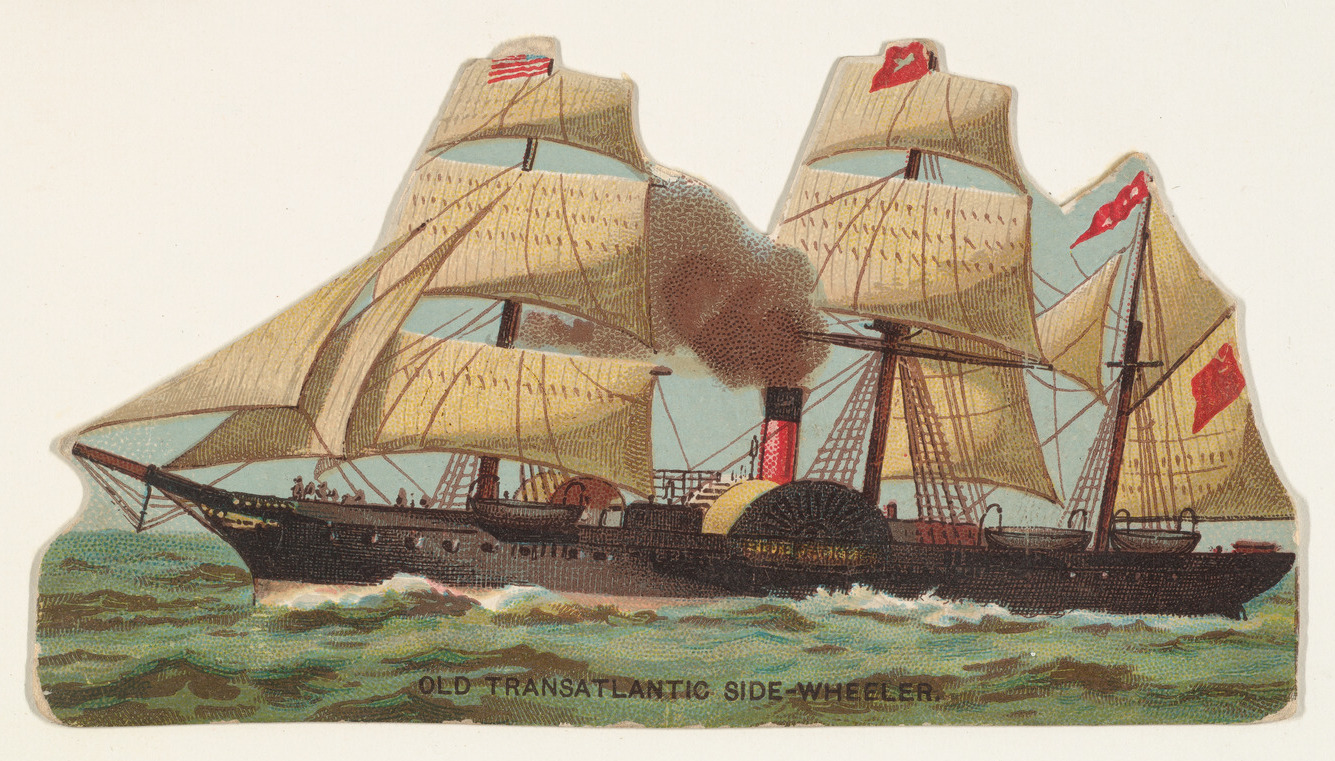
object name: print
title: Old Transatlantic Side-Wheeler, from the Types of Vessels series (N139) issued by Duke Sons & Co. to promote Honest Long Cut Tobacco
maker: w. duke, sons & co.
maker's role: publisher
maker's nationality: american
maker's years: 1870-1920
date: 1889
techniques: color lithograph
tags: ships